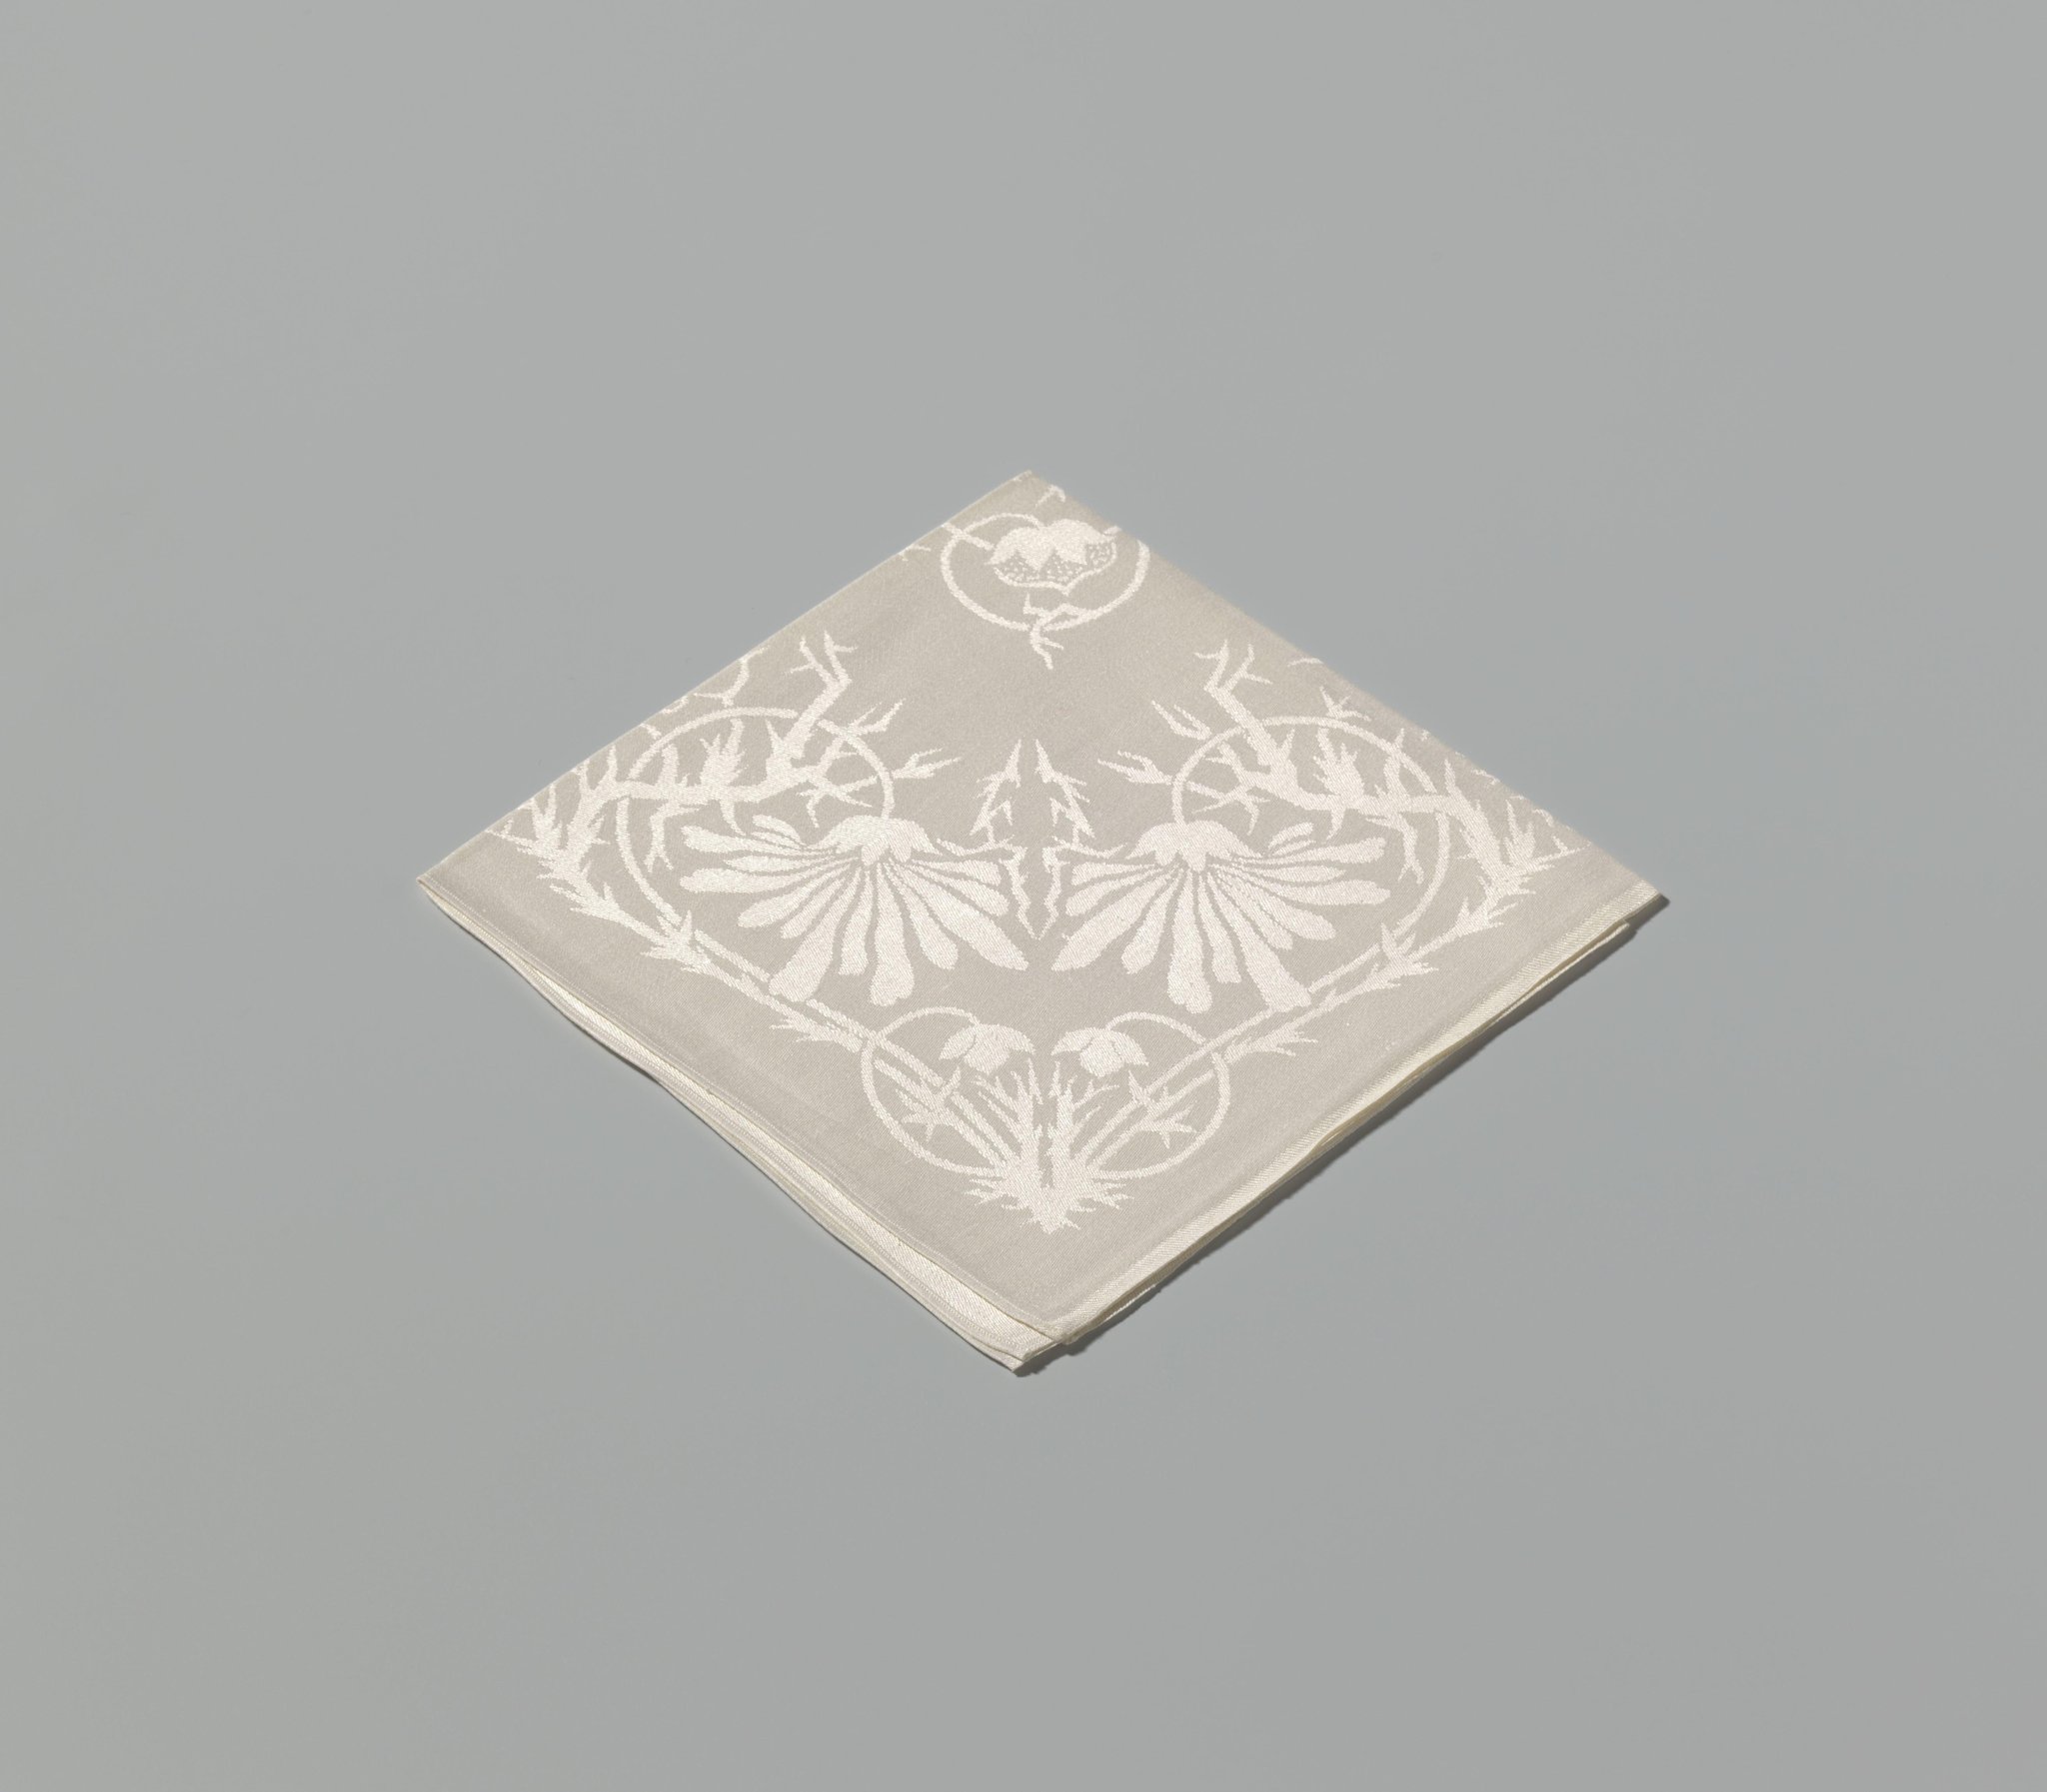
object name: vingerdoek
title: Vingerdoek van linnendamast met dessin Marguerite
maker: cornelis van der sluys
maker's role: print maker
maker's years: 1881-1944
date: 1904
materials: linen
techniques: damask, weave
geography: eindhoven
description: Vingerdoek van linnendamast met een bloempatroon: motief Marguerite, dessin nr. 500. De vingerdoek hoort bij elf vingerdoeken, dertien servetten en een tafellaken.